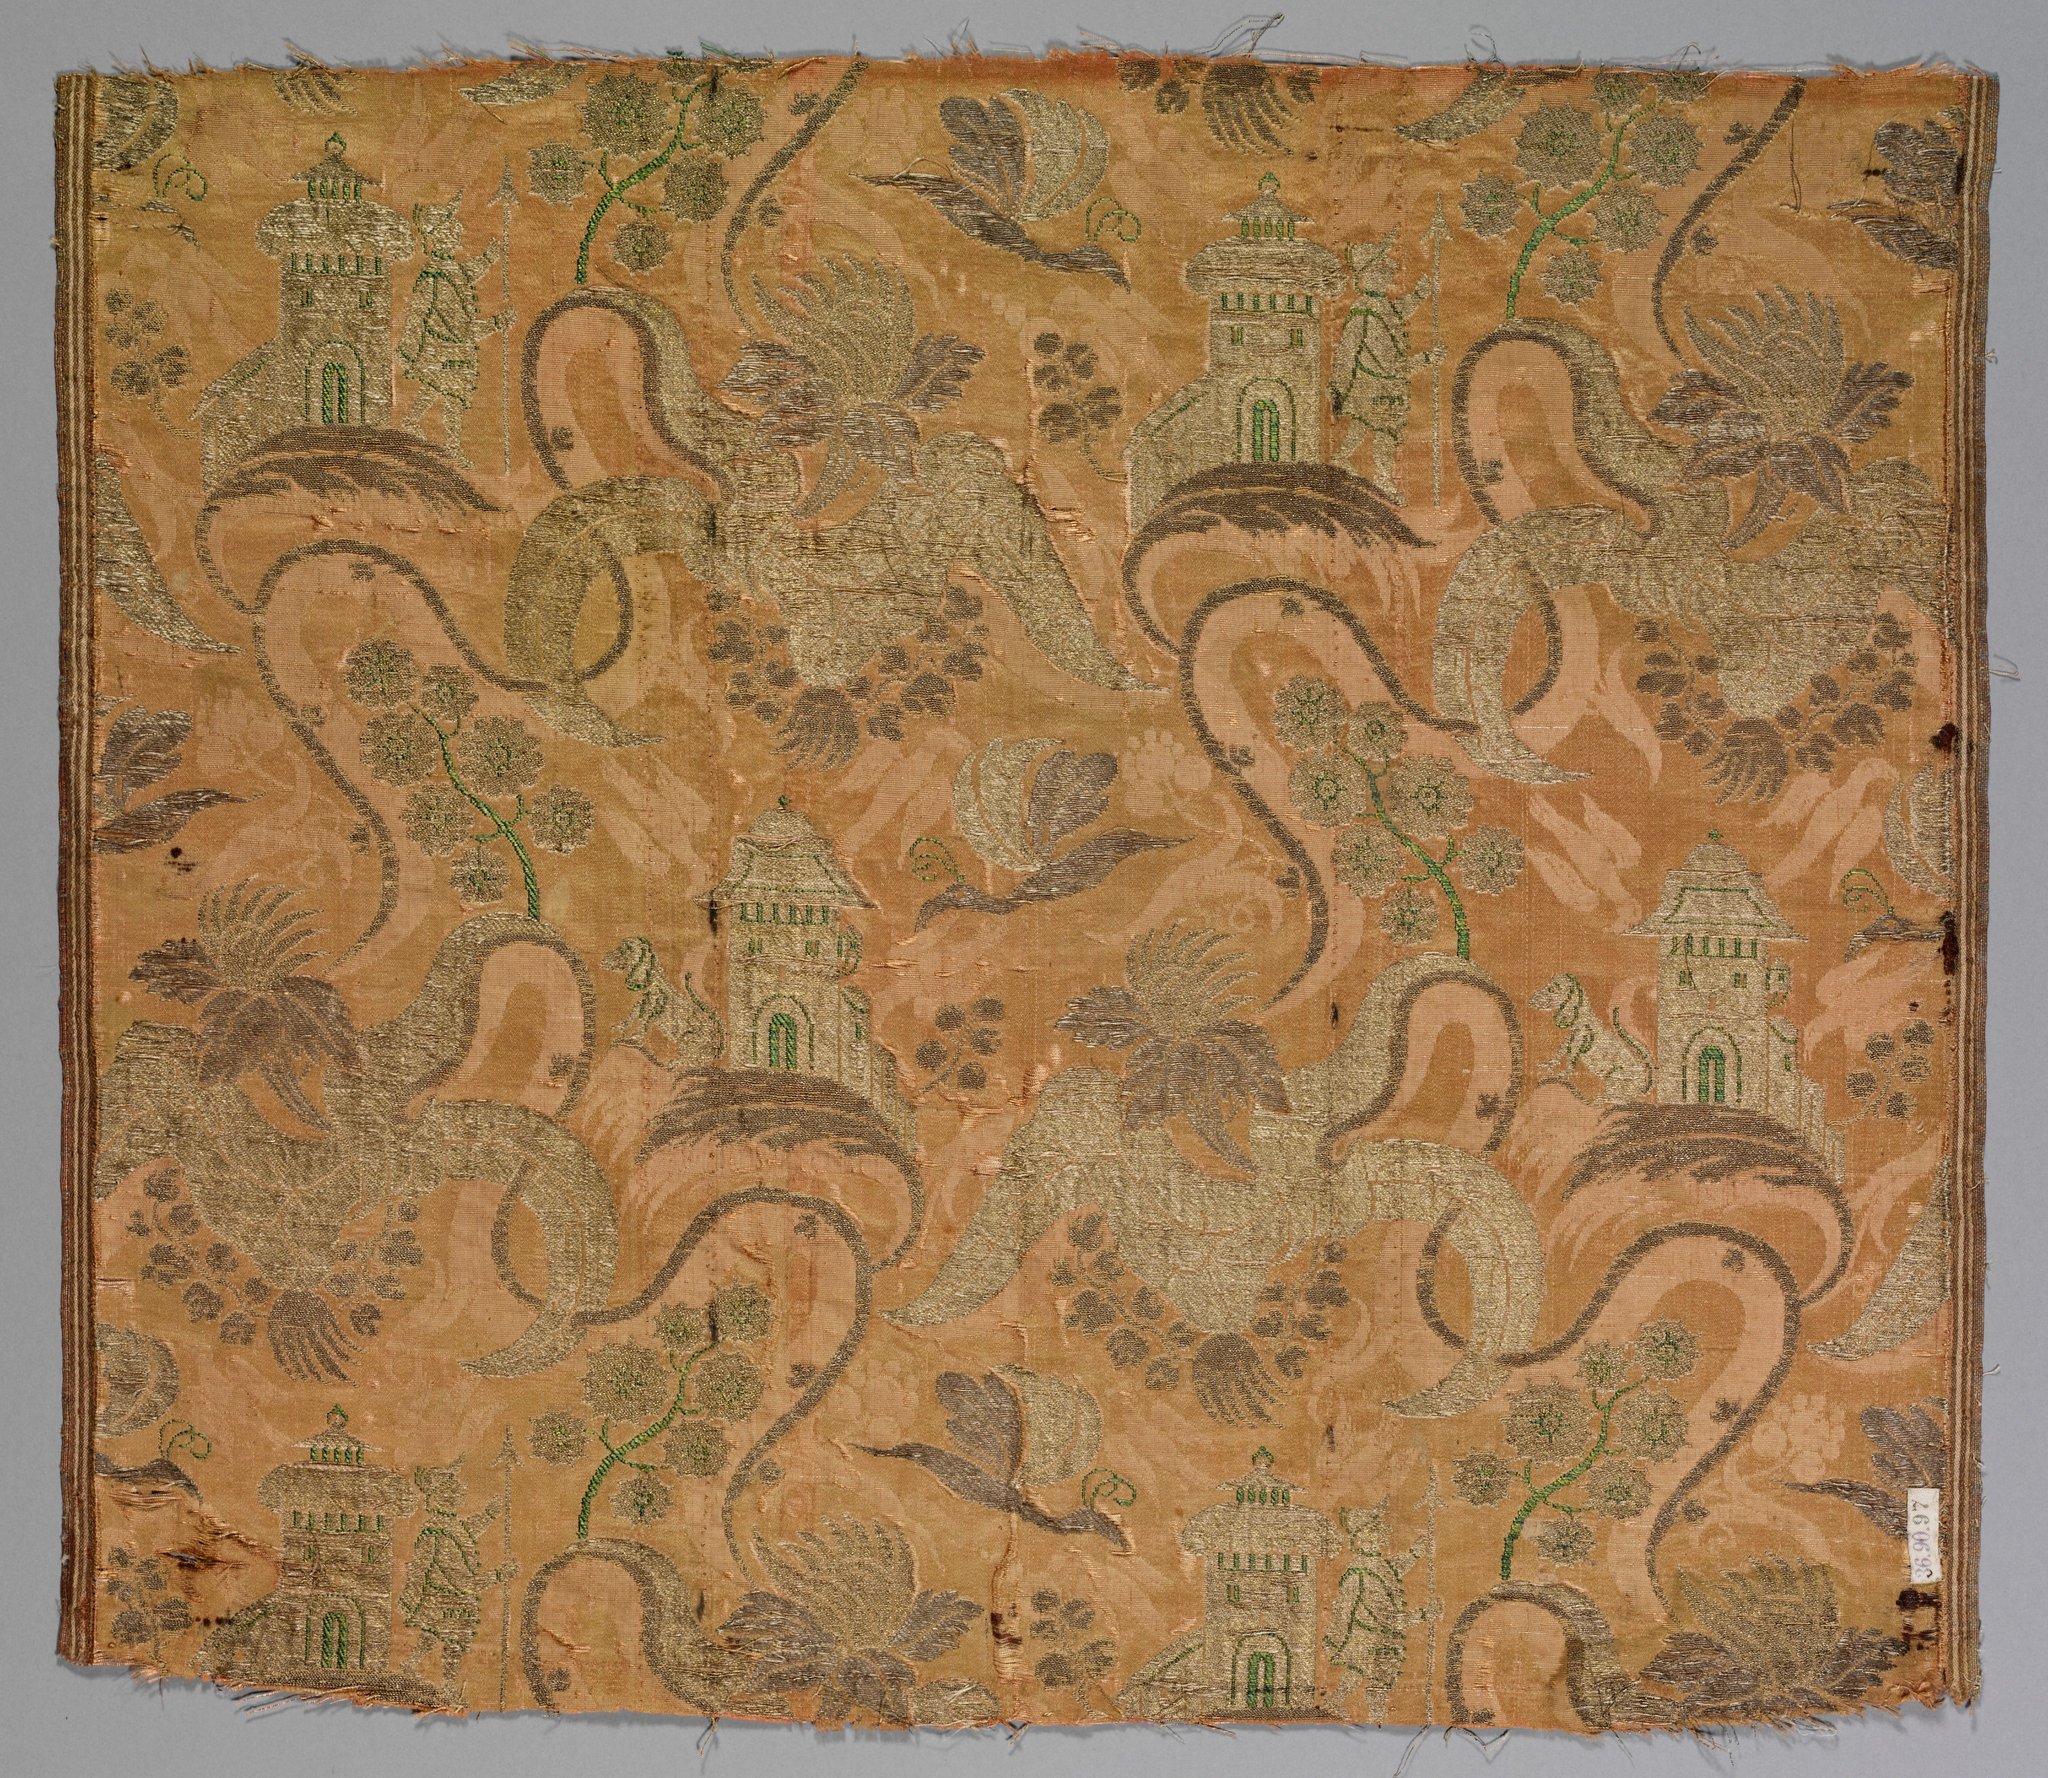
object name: piece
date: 1700-1715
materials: metal thread, silk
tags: buildings,men,flowers